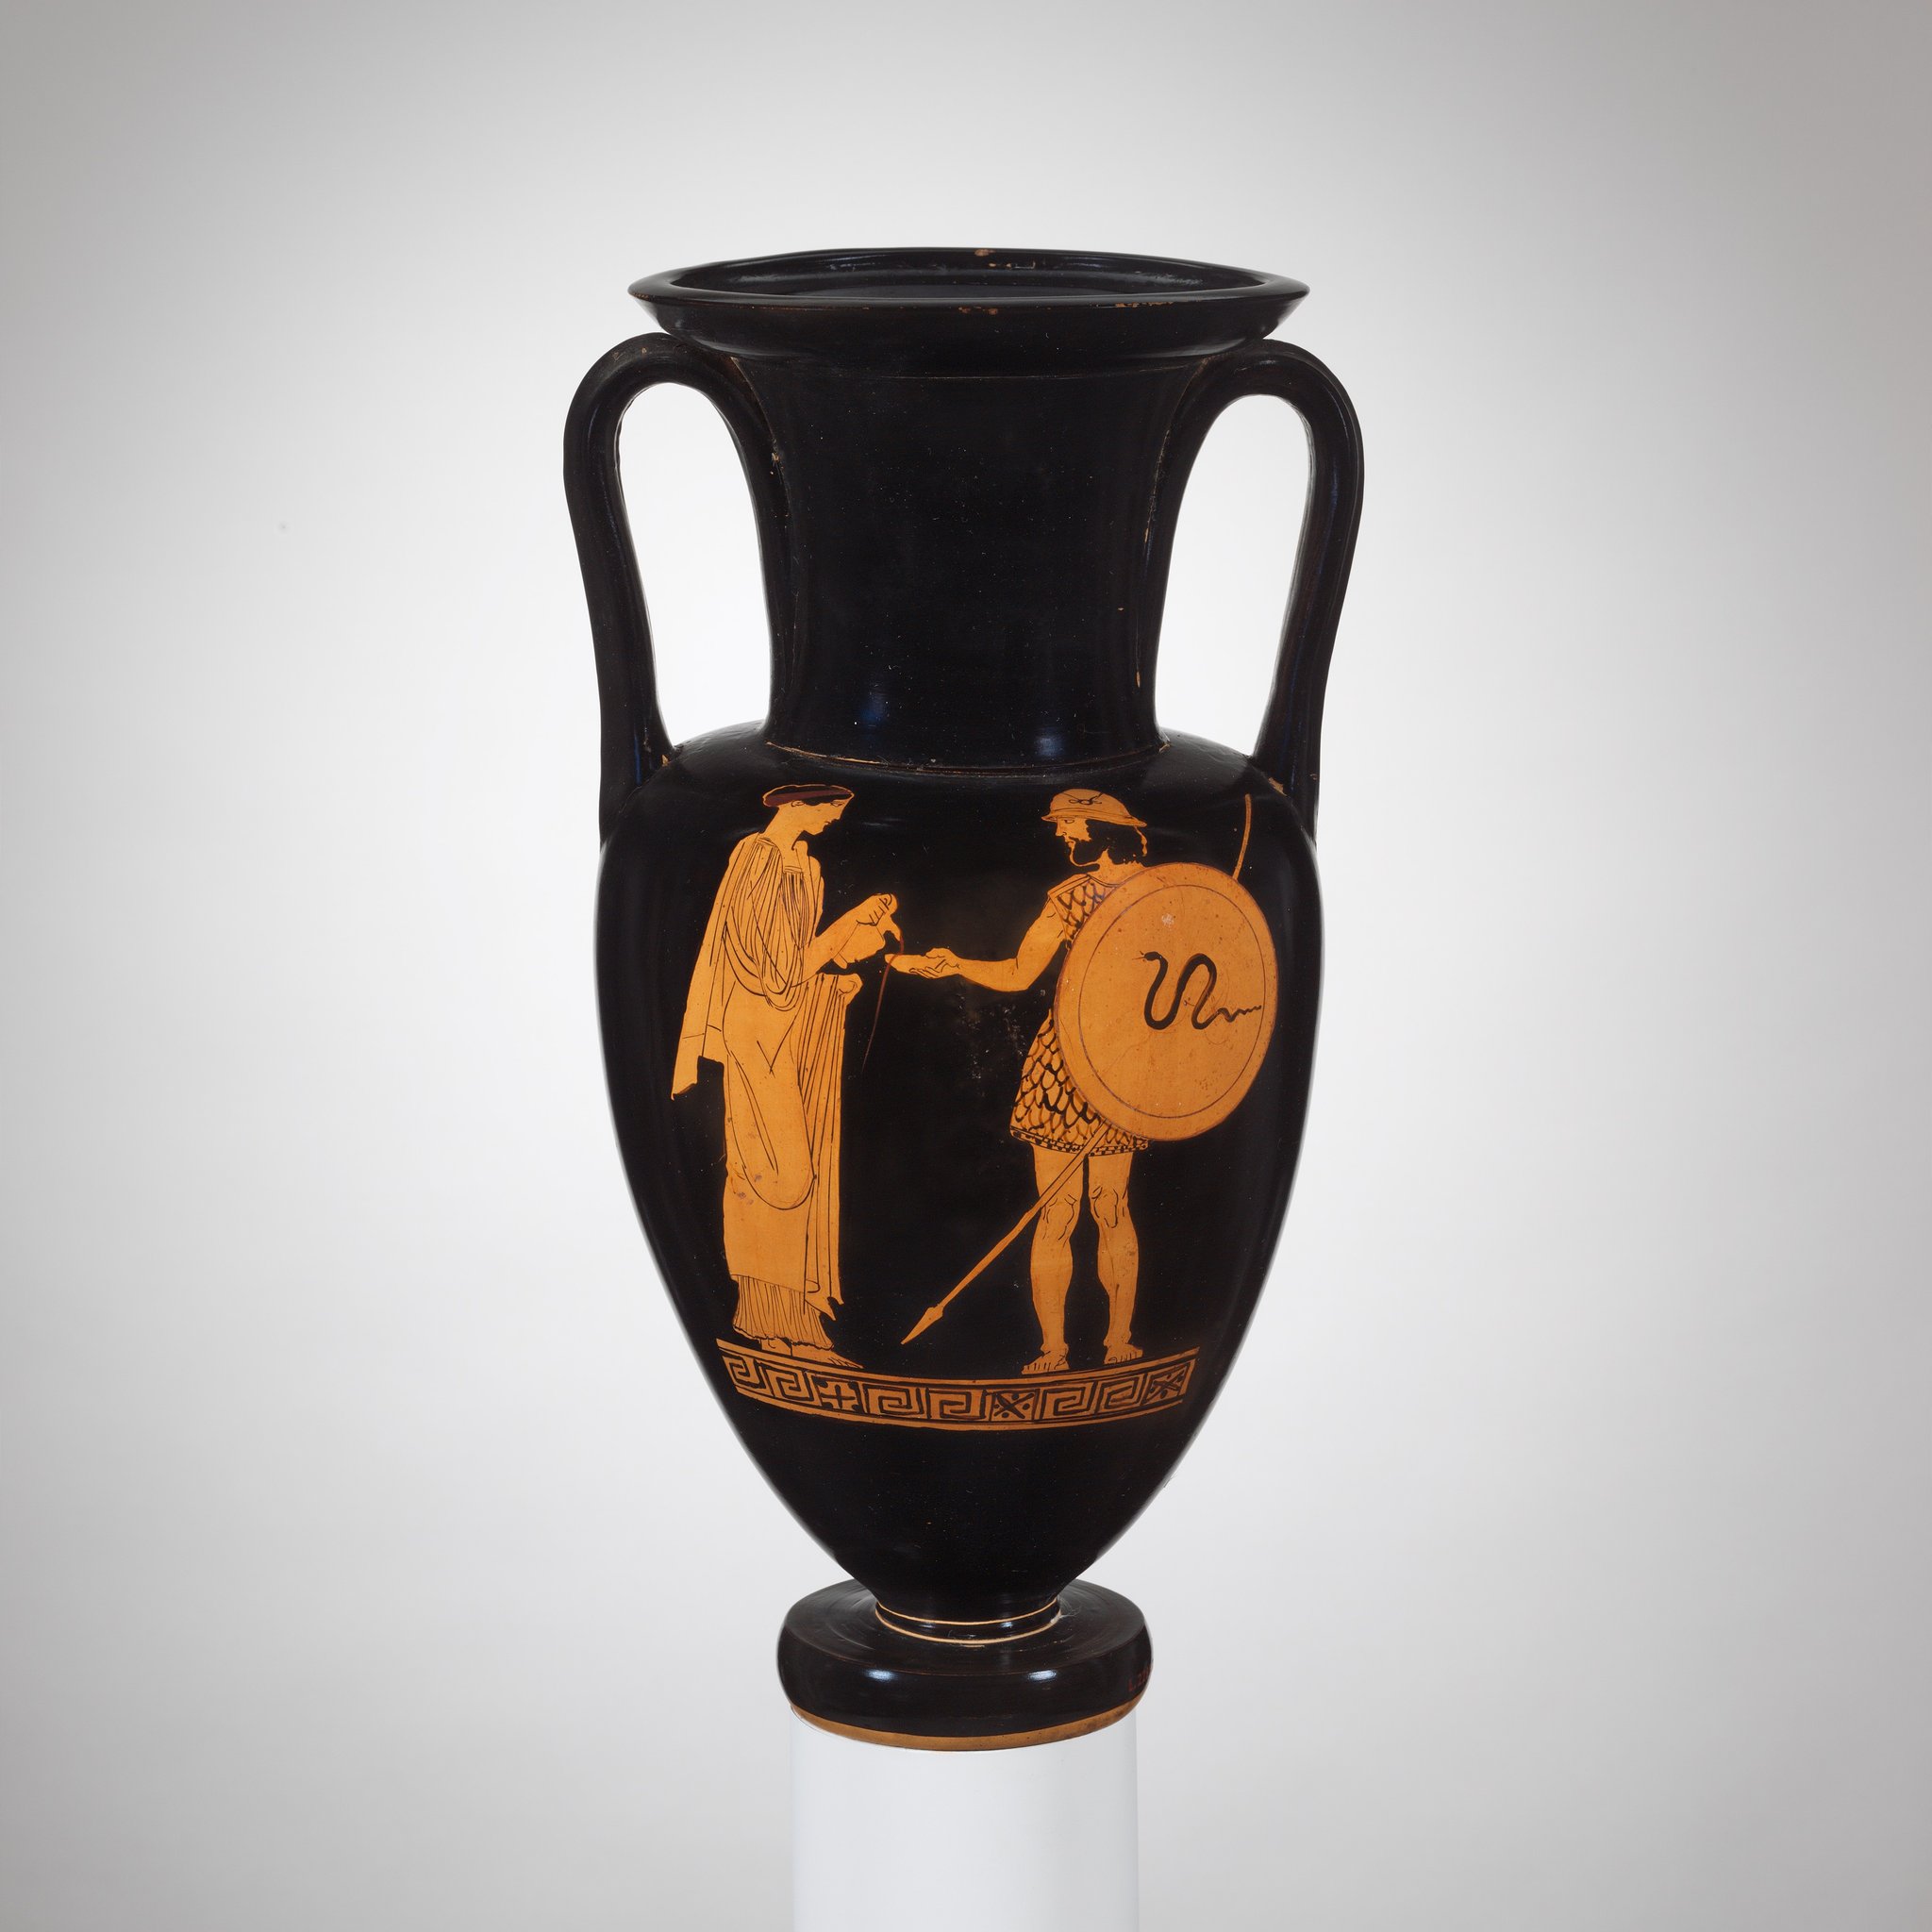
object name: nolan neck amphora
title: Terracotta Nolan neck-amphora (jar)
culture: greek, attic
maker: westreenen painter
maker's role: artist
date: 450-440 BCE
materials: terracotta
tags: shields,men,women,warriors